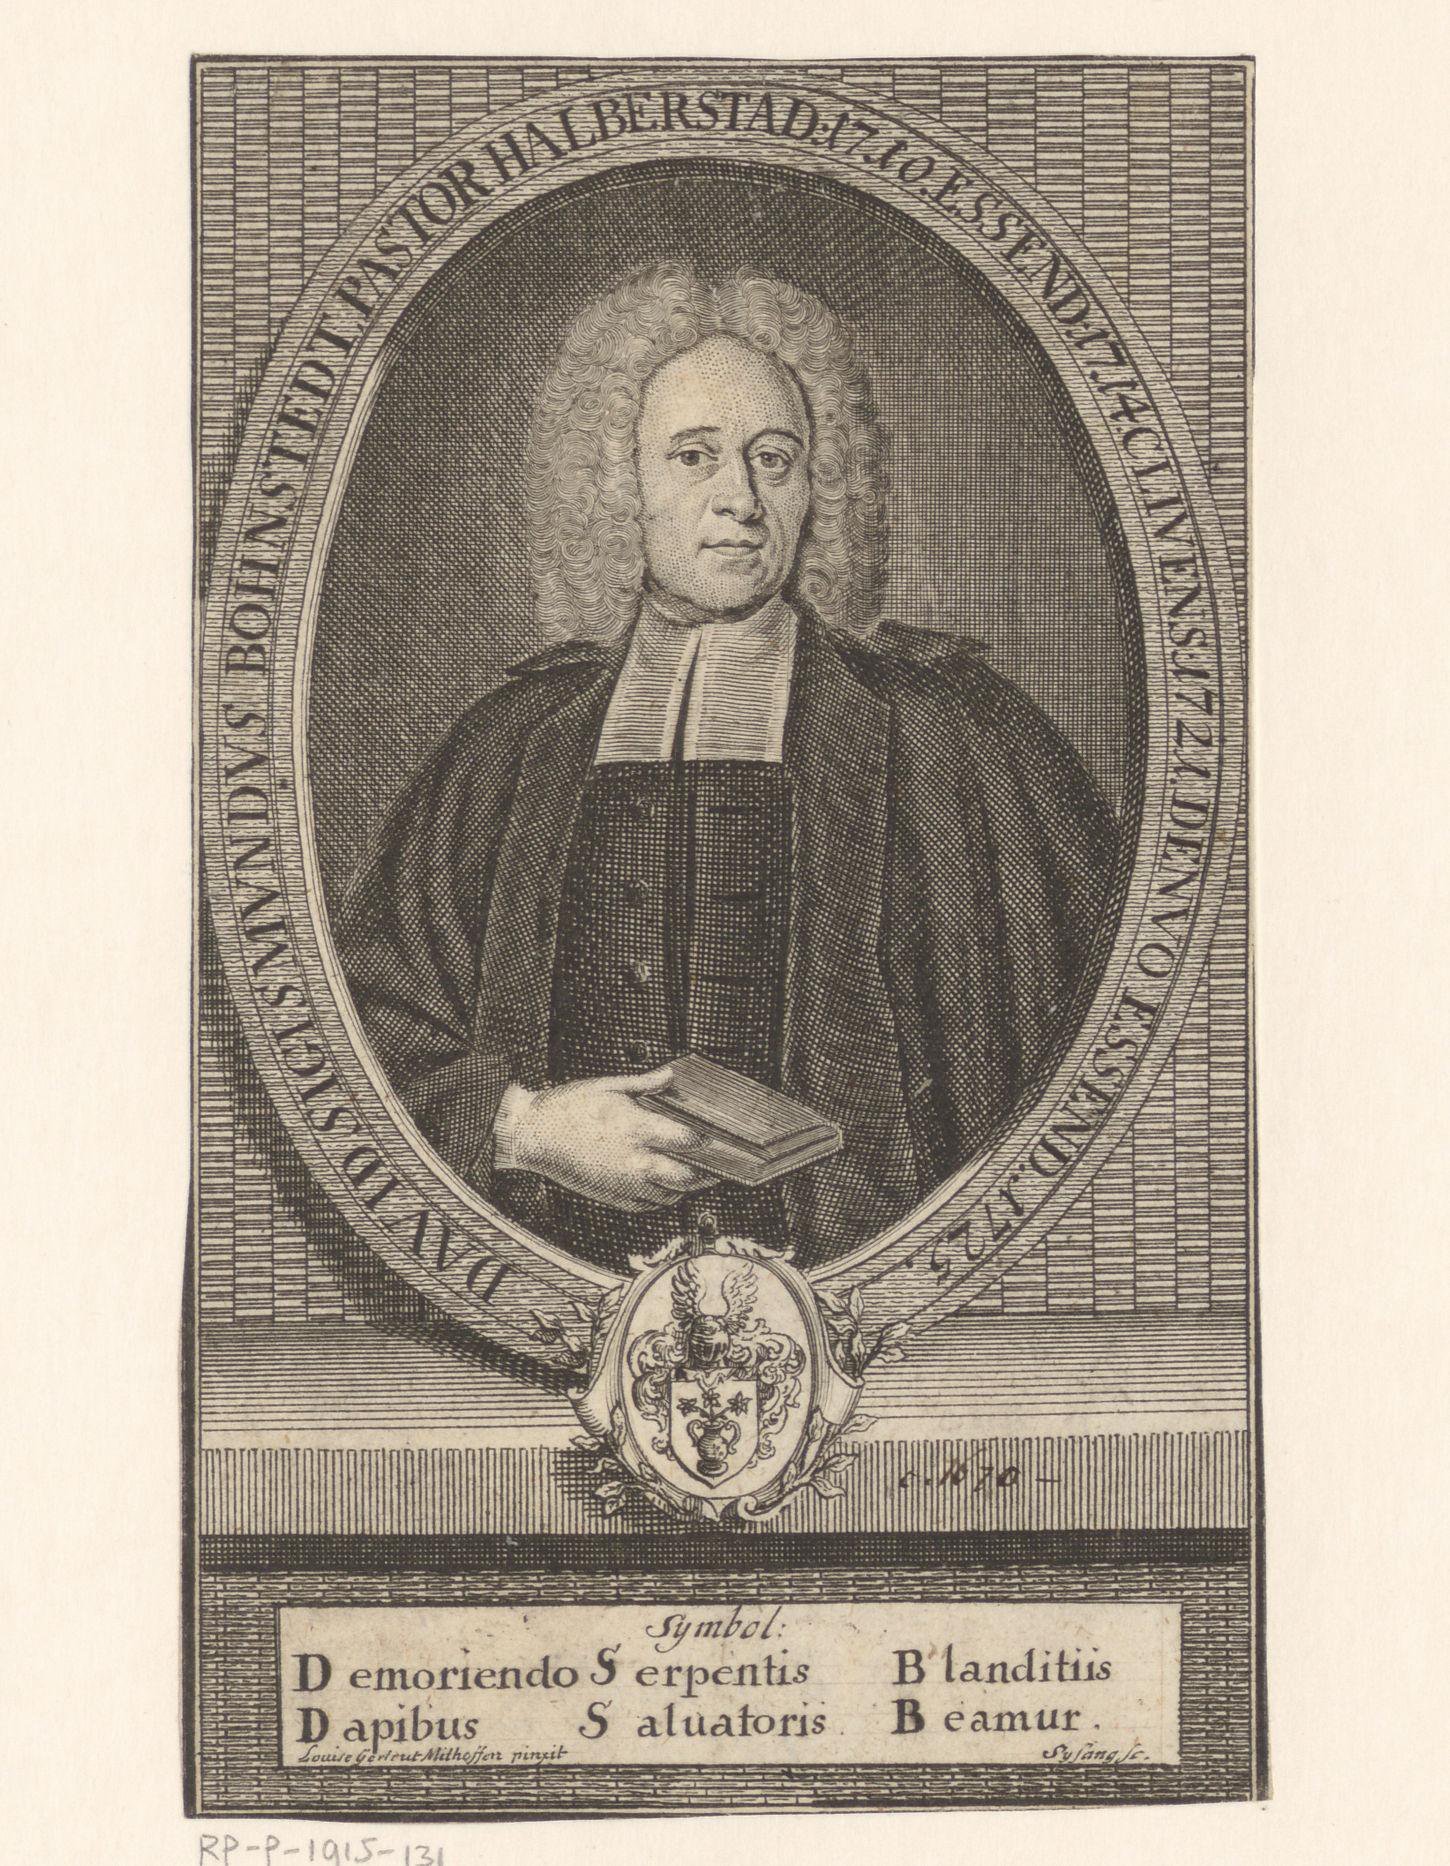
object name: print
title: Portret van David Sigismund Bohnstedt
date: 1713-1757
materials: paper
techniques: engraving, etching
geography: germany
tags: essen, historical persons, armorial bearing, heraldry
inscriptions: collector's mark: Lugt 2228, inscription: ‘c. 1670-’